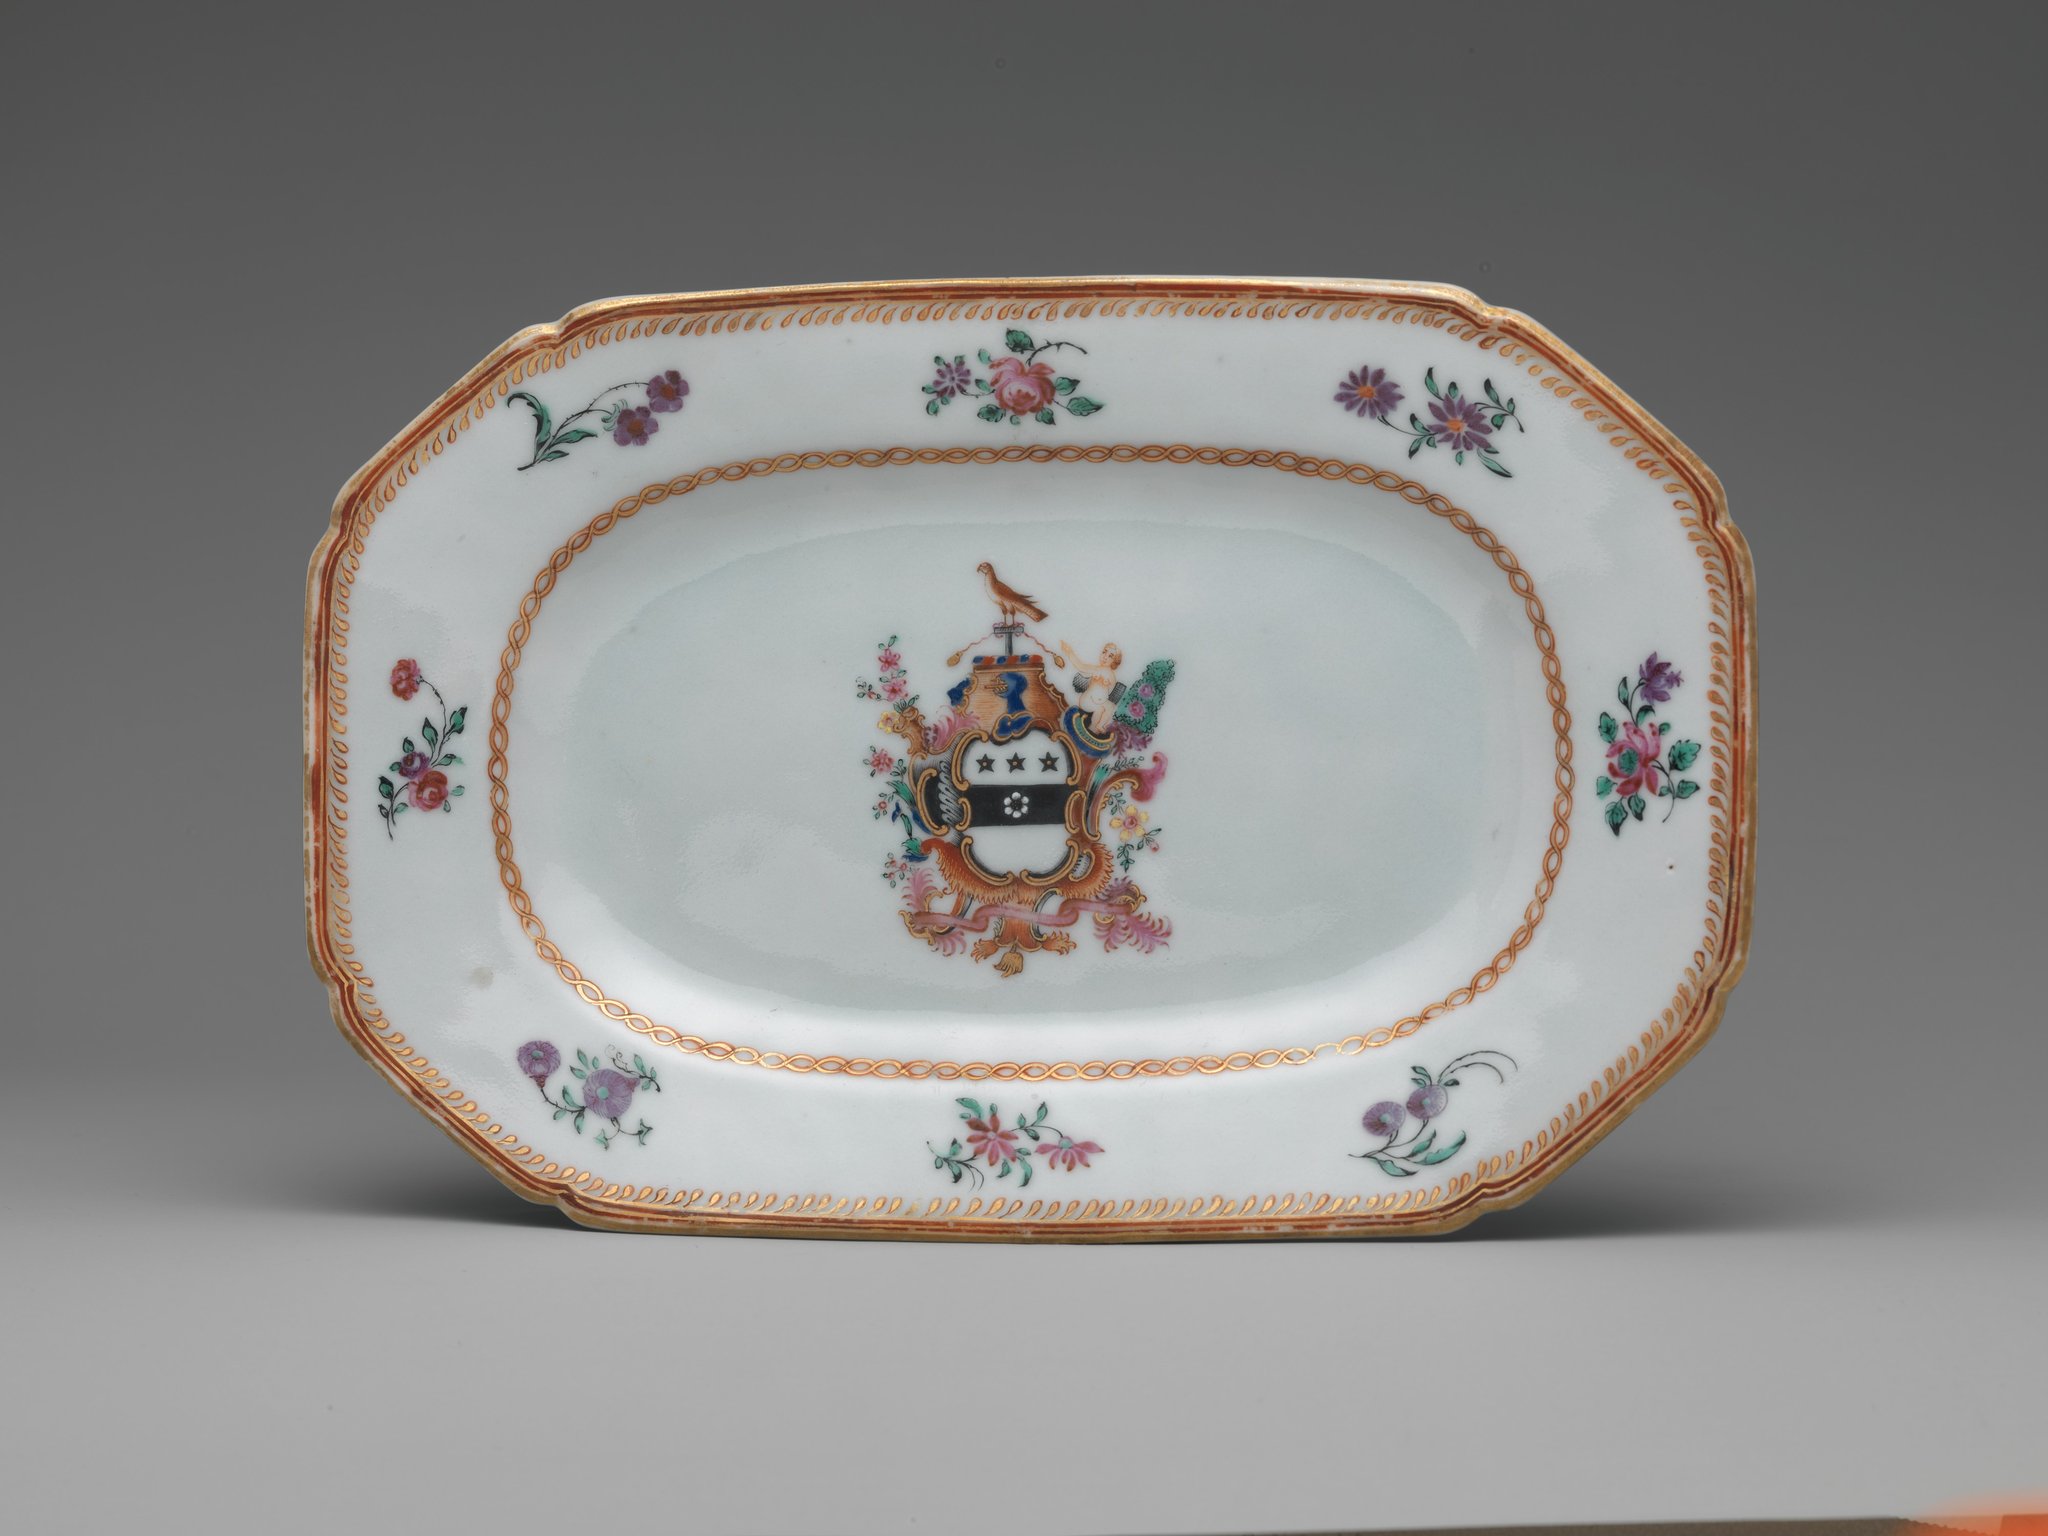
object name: platter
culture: chinese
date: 1785-1790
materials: porcelain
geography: china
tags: birds,flowers,coat of arms